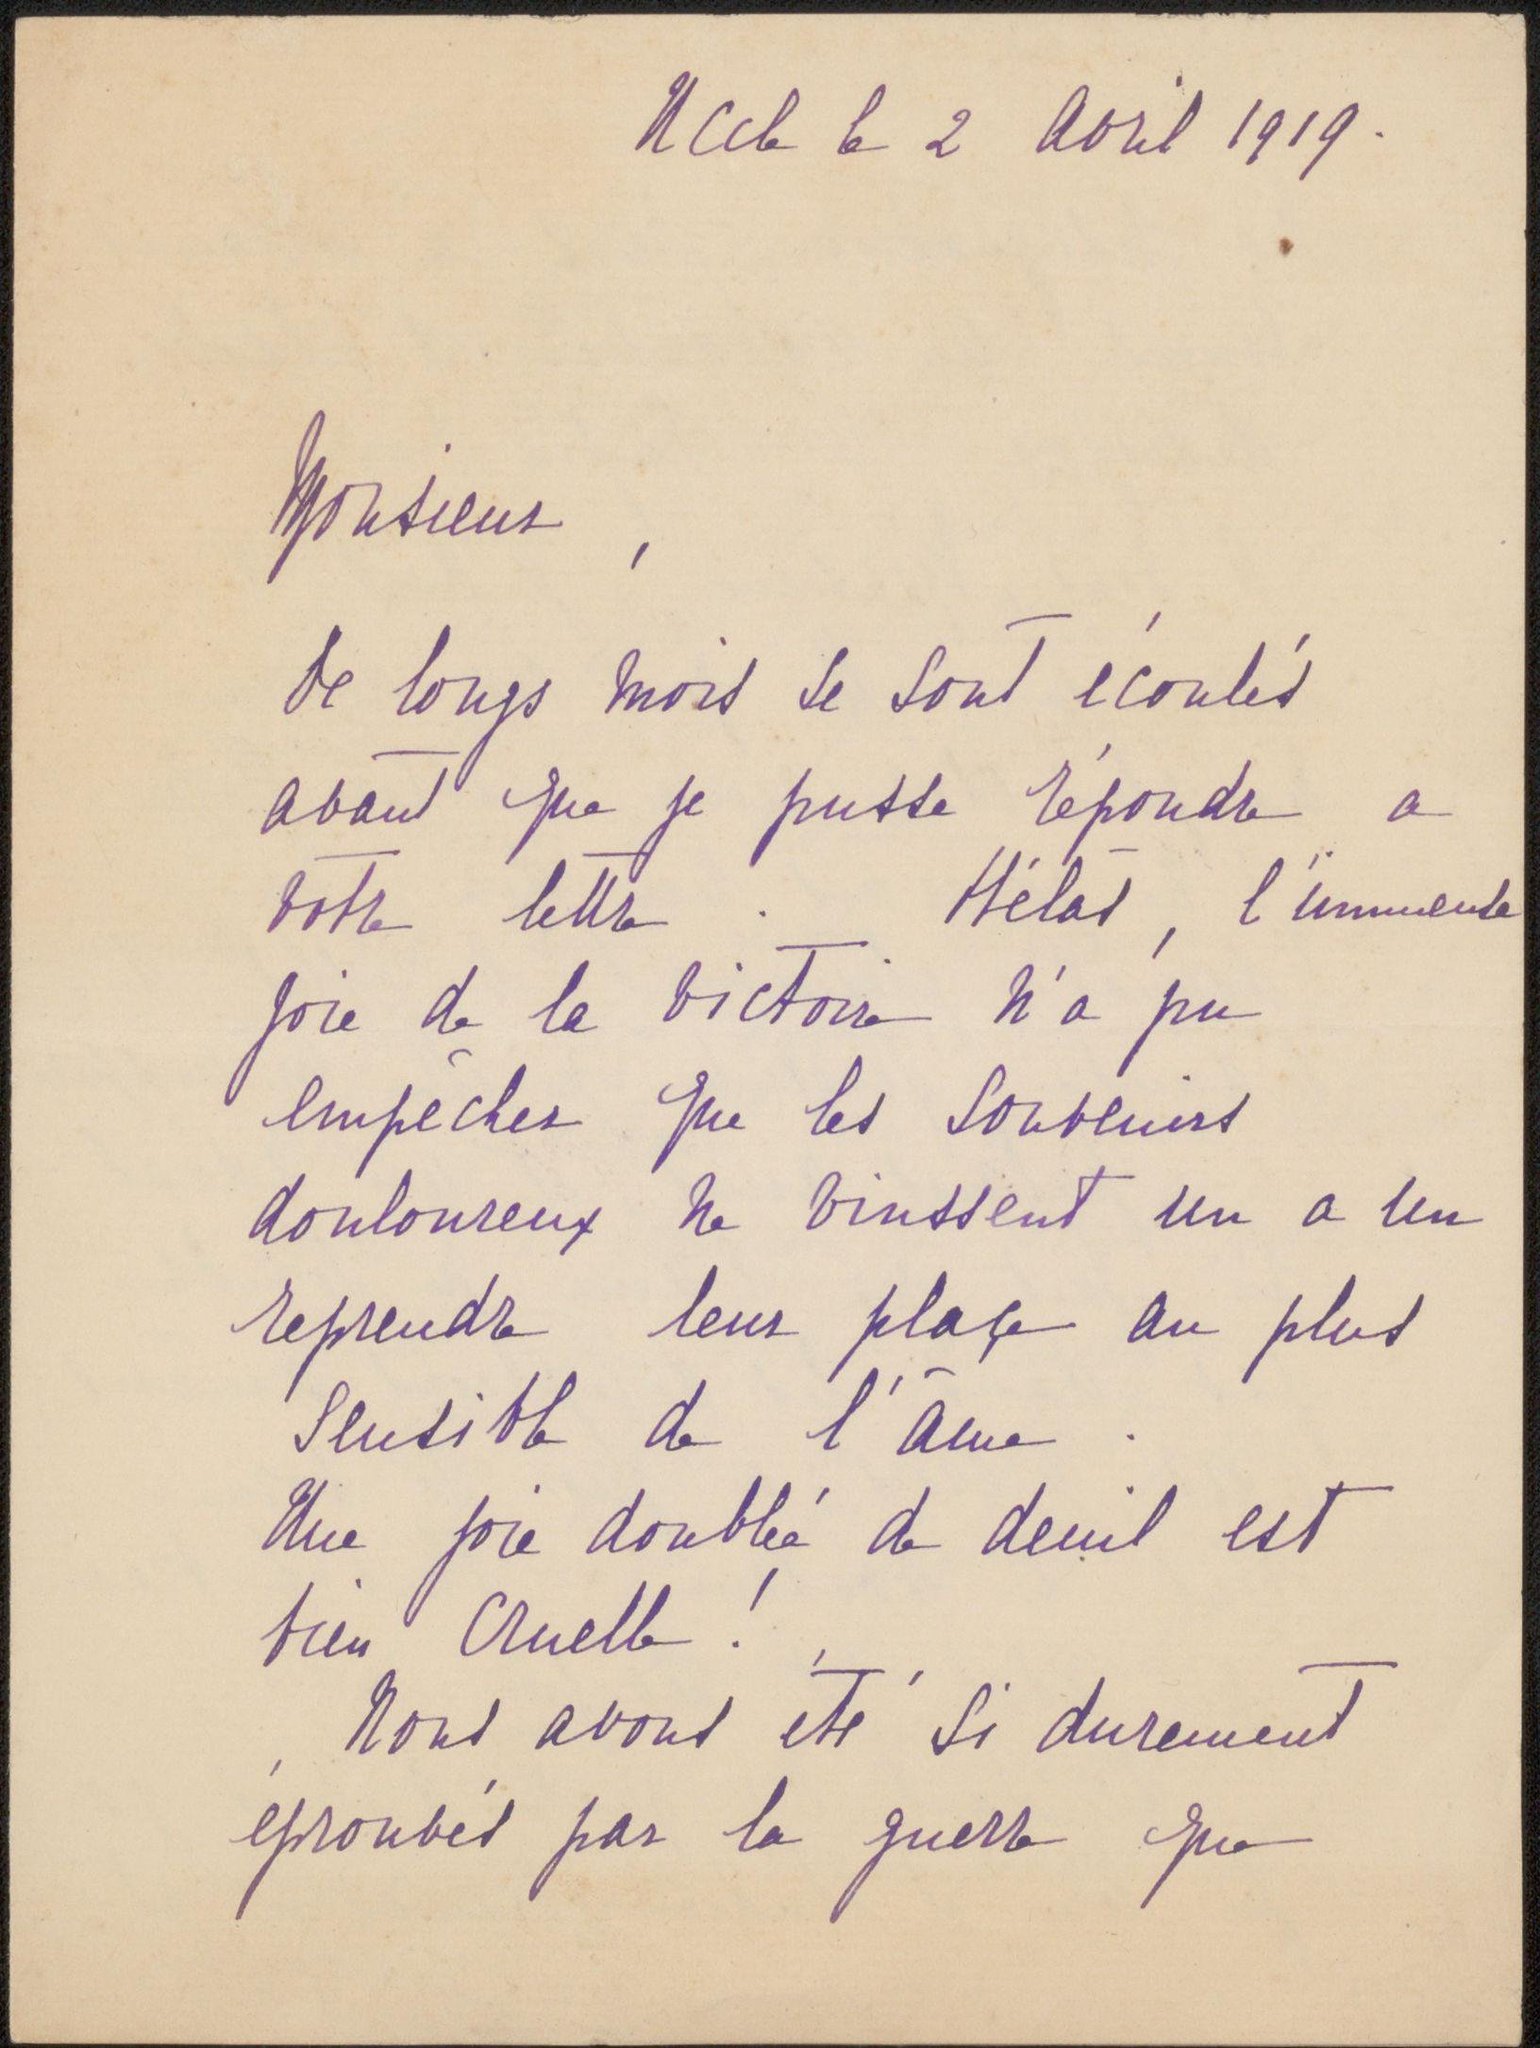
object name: letter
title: Brief aan Philip Zilcken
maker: germaine wenziner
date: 1919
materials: ink, paper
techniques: pen, writing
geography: ukkel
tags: the hague, painter, draughtsman, philip zilcken, painting (including book-illumination, miniature-painting), diseases, switzerland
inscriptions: collector's mark: ‘RPK’, watermark